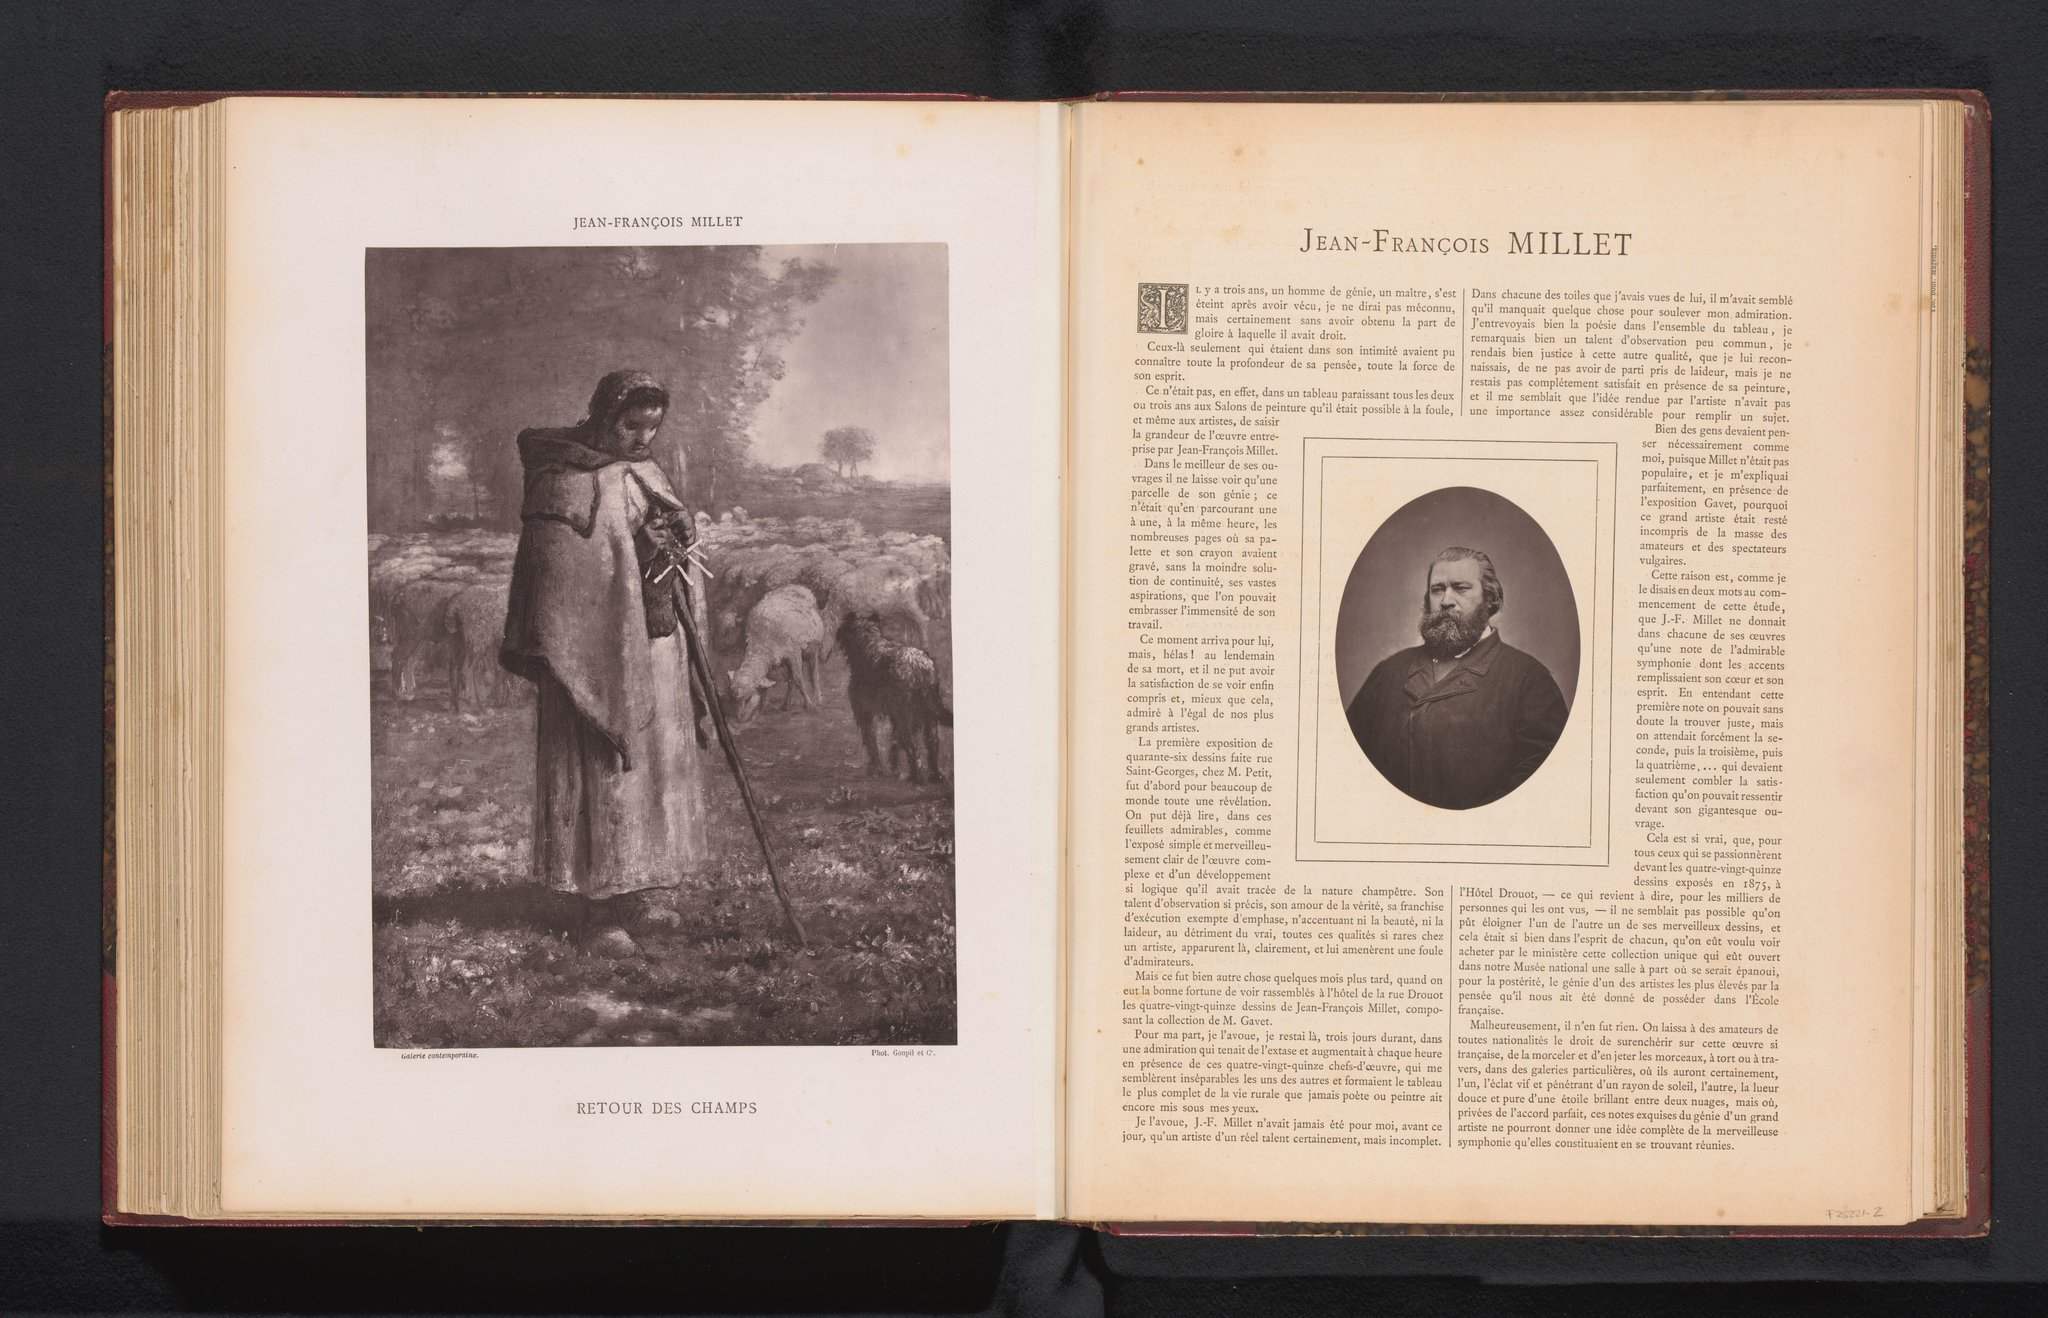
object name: page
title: Portret van Jean-Francois Millet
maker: Anonymous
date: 1867-1878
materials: paper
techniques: woodburytype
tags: painter, print maker, draughtsman, jean françois millet, adult man, historical persons